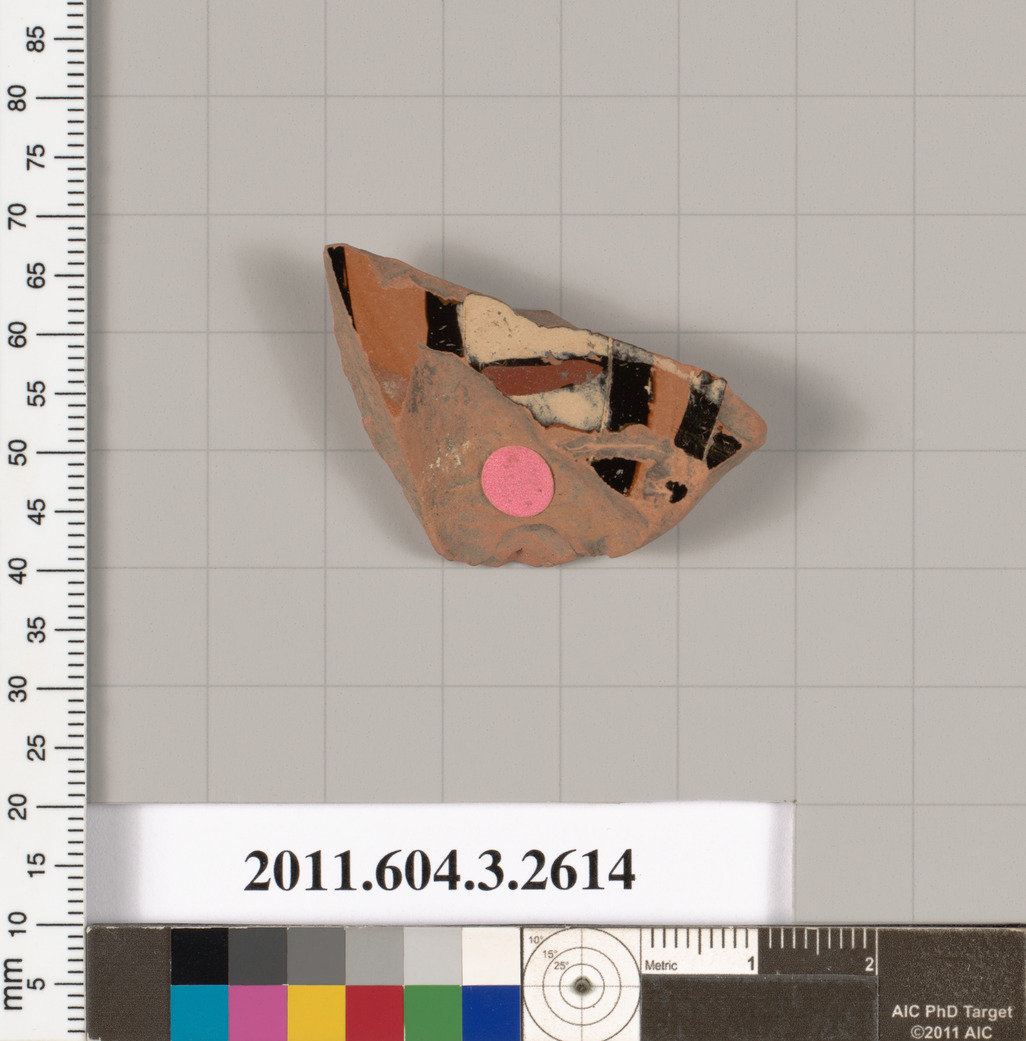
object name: kylix fragment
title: Terracotta fragment of a kylix (drinking cup)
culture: greek, attic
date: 550-526 BCE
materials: terracotta